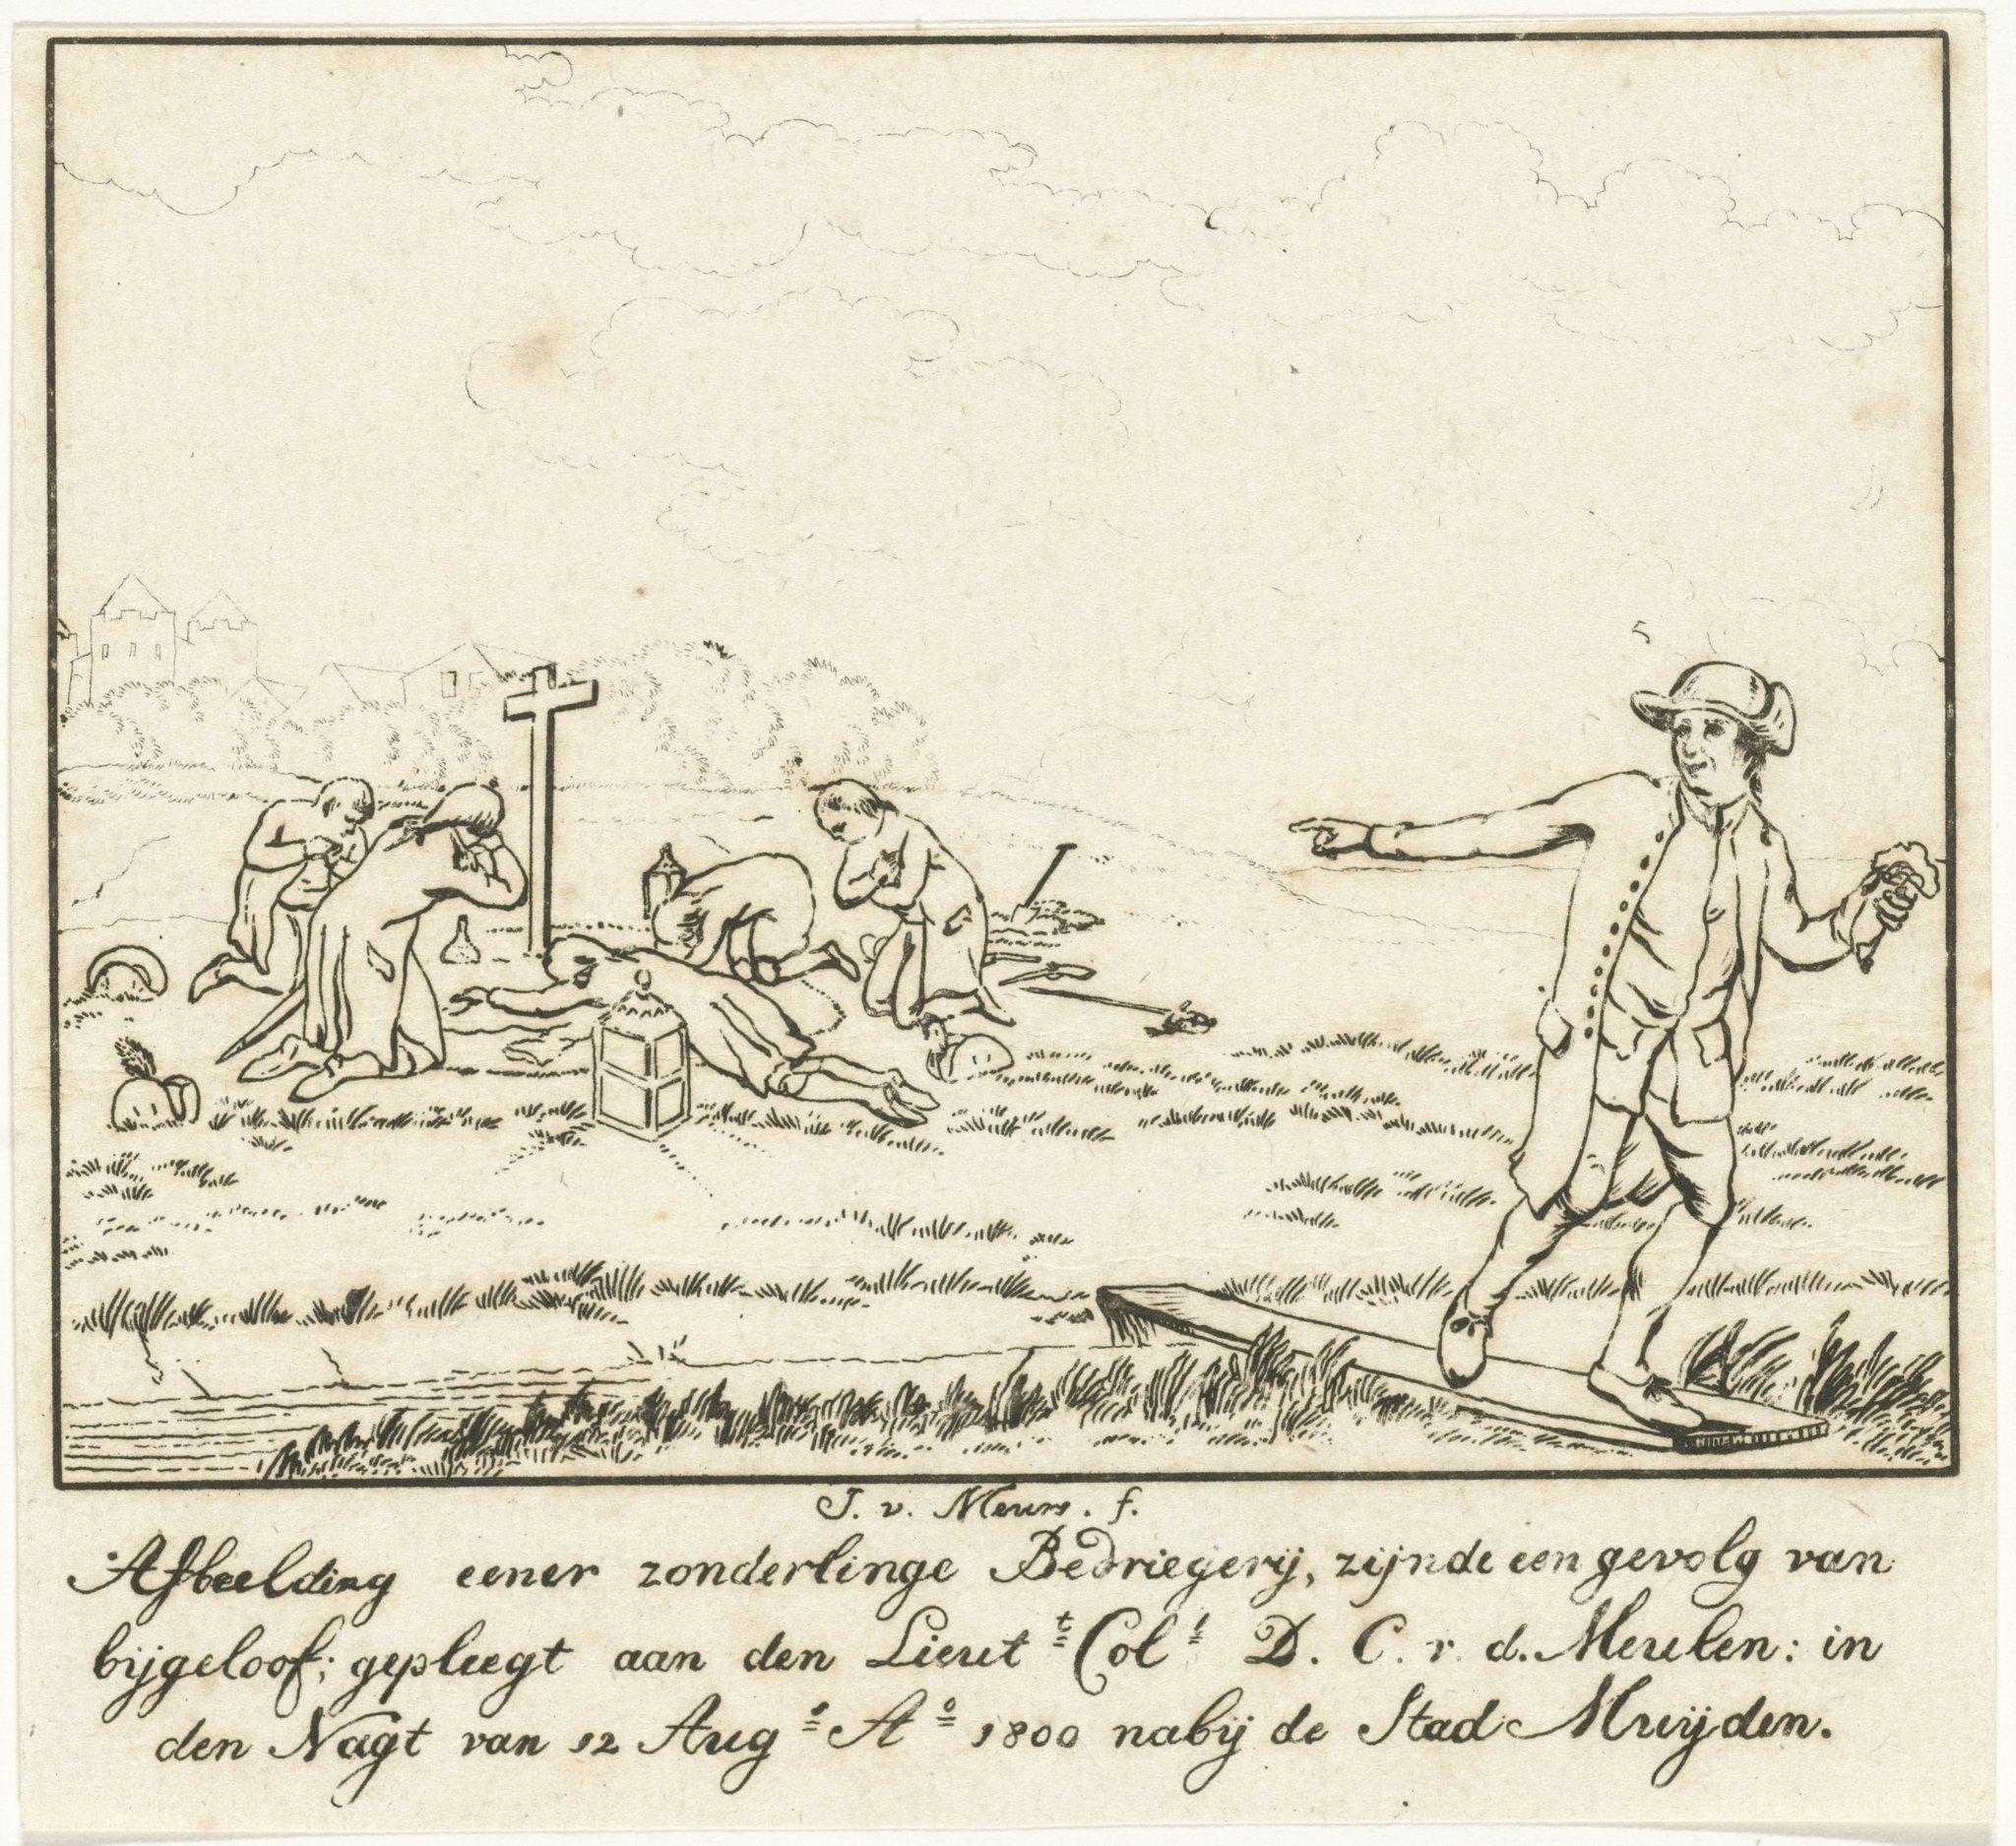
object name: print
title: Bedrog van Muiden, 1800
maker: jacobus van meurs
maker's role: draughtsman, painter, print maker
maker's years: 1760-1824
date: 1800-1802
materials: paper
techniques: etching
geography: amsterdam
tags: cheat, deceit; 'fraude', 'inganno' (ripa) (+ 'exemplum', representation of exemplary (historical) event), the cross ~ symbols of christ, thief, kneeling figure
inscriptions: collector's mark: Lugt 2228, collector's mark: Lugt 2760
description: Luitenant kolonel D. C. van der Meulen en vier andere mannen liggen geknield rond een kruis. Rondom hen lantaarns en een schop. Op de voorgrond vlucht een oplichter, die aan de mannen een schat beloofde, met een zak geld weg. Op de achtergrond het Muiderslot.